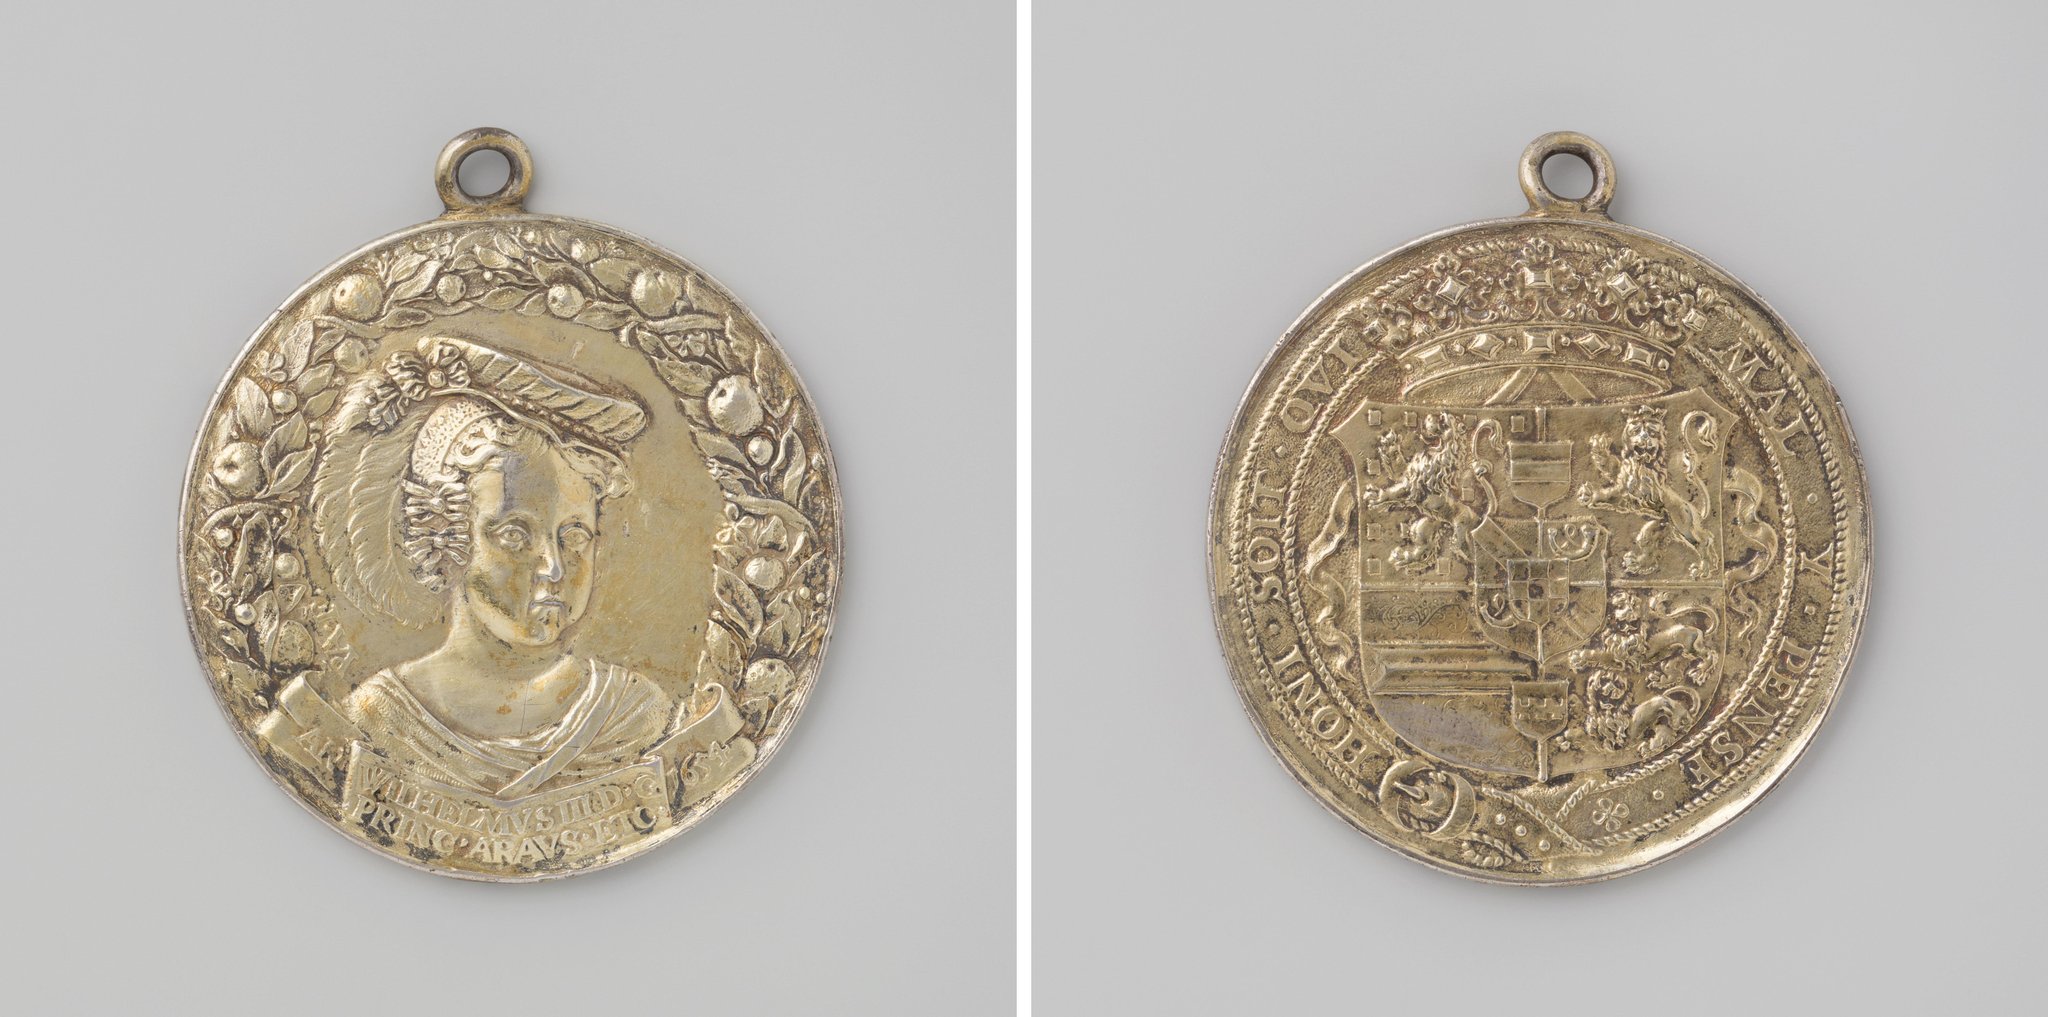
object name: insignia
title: Willem III, prins van Oranje-Nassau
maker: pieter van abeele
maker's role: draughtsman, jeweler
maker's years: 1608-1684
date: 1654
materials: silver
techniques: casting, gilding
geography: amsterdam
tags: the hague, william iii (prince of orange and king of england, scotland, and ireland)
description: Zilveren penning. Voorzijde: borststuk jongen met vederbaret boven wimpel met opschrift, binnen krans van oranjetakken. Keerzijde: gekroond wapenschild binnen omschrift